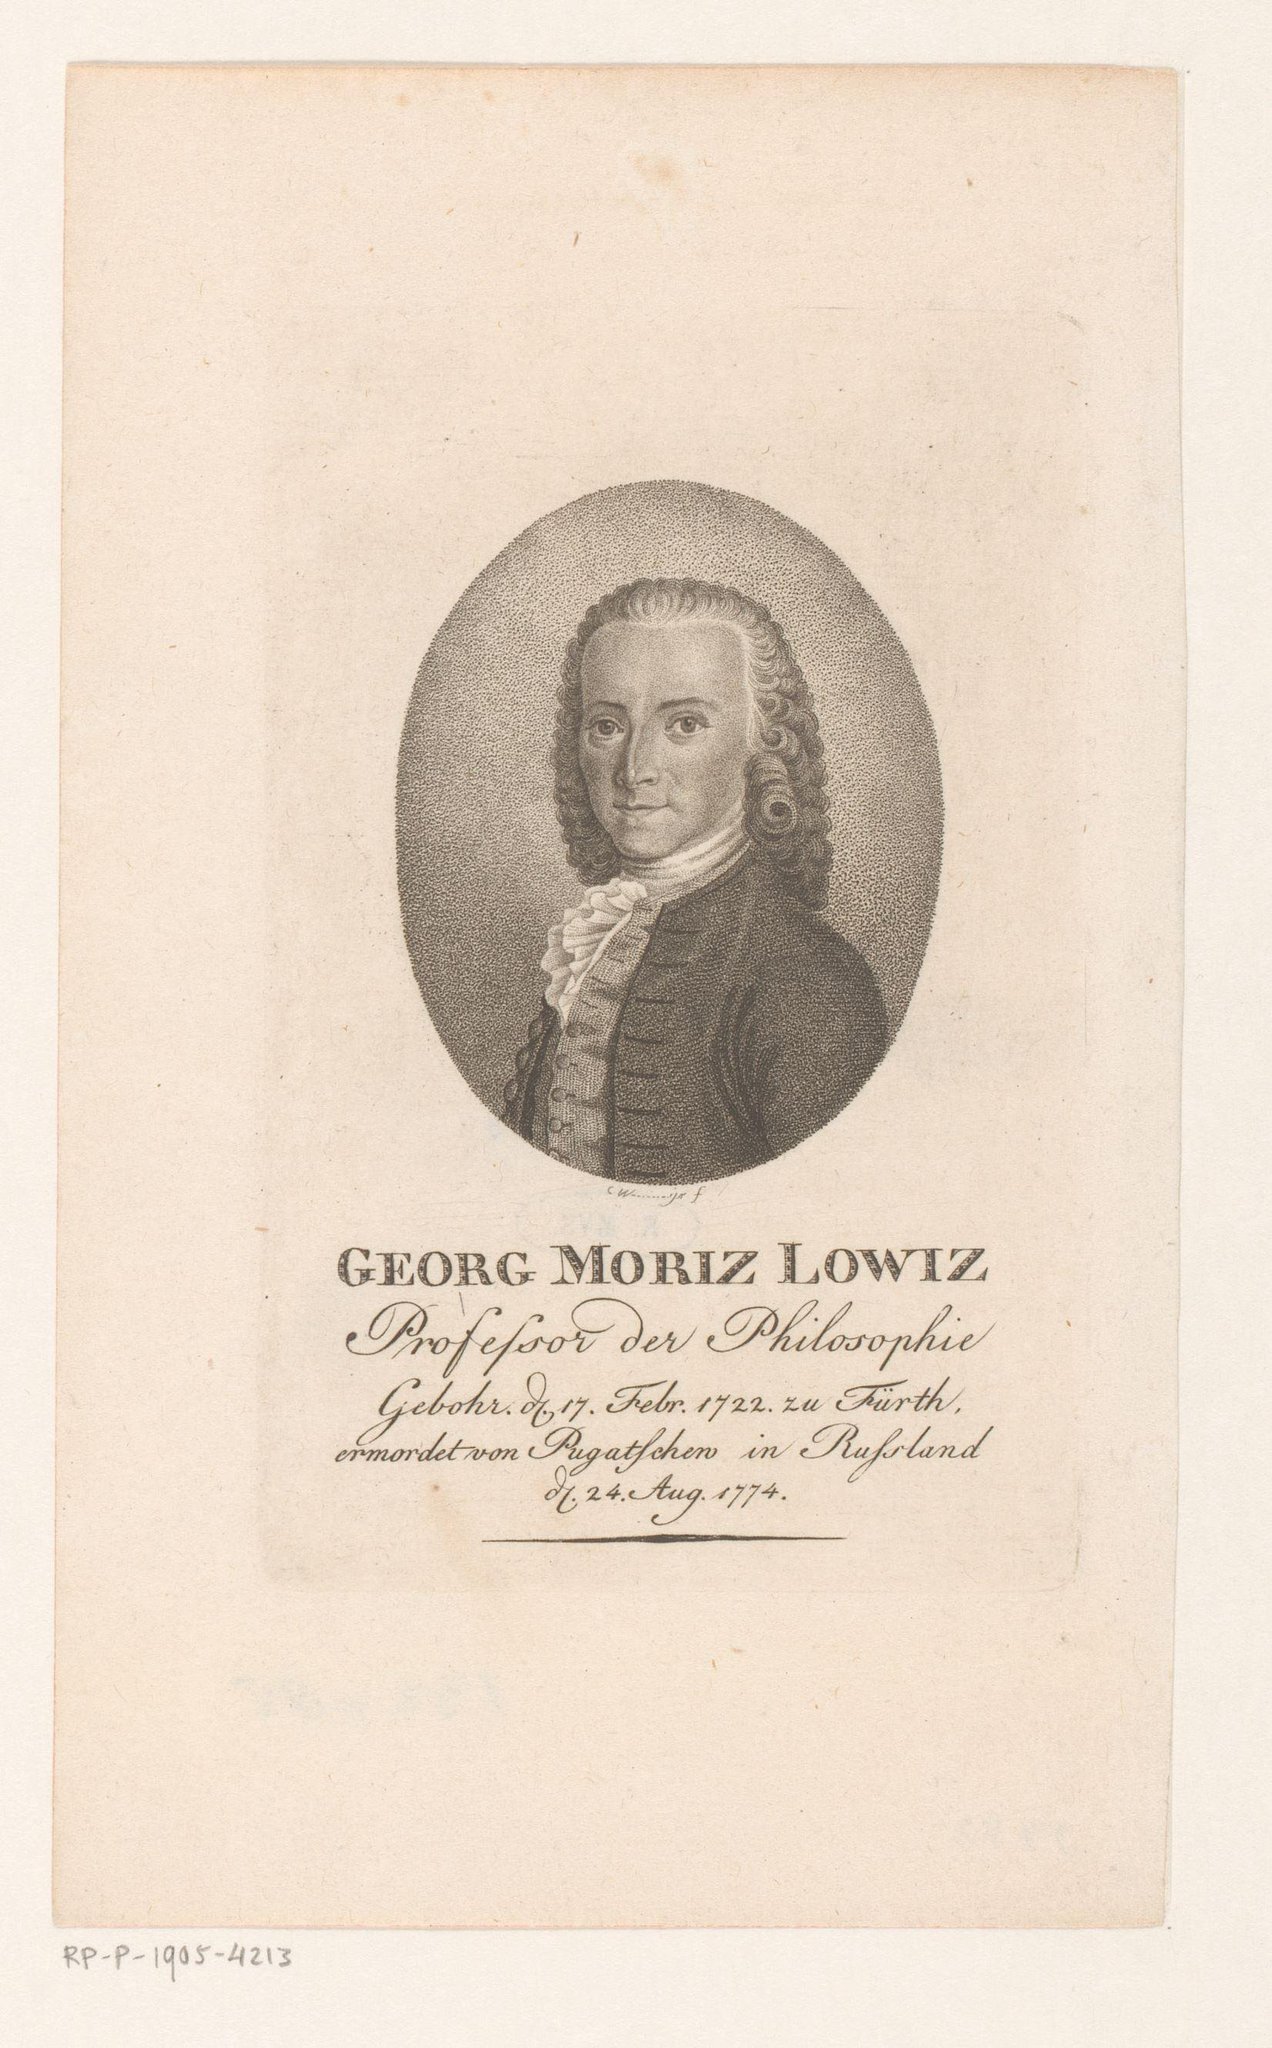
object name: print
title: Portret van Georg Moritz Lowitz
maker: konrad westermayr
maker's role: print maker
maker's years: 1765-1834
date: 1775-1834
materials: paper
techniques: engraving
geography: germany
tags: russia, georg moritz lowitz, historical persons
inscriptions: collector's mark: Lugt 2228